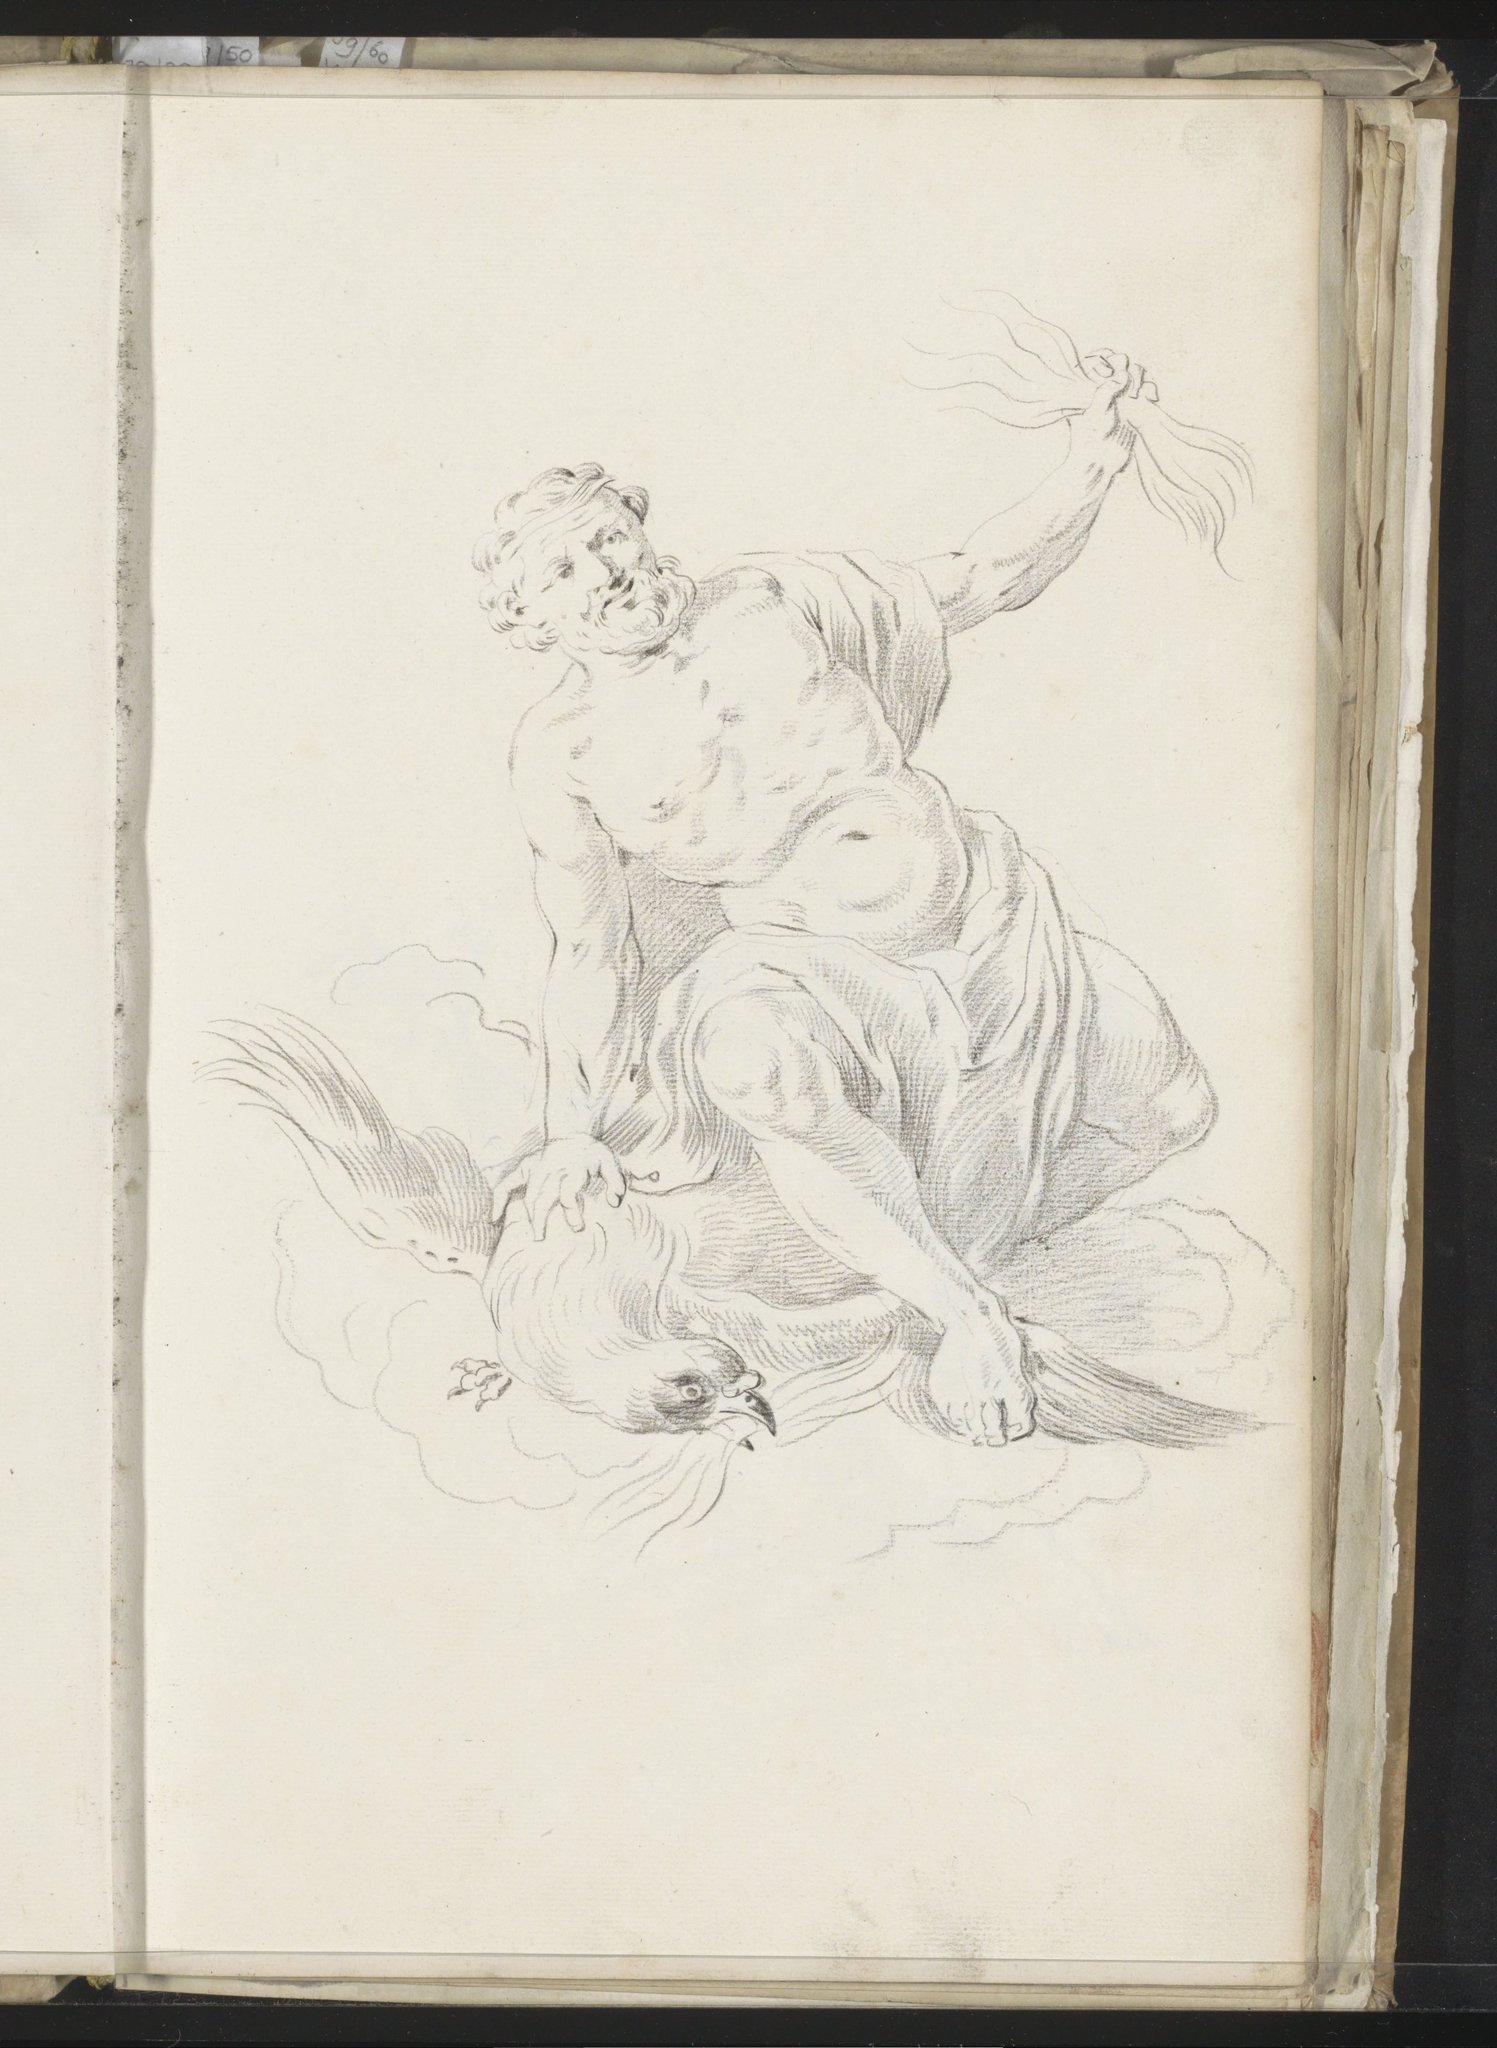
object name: sketchbook leaf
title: Jupiter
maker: jacob toorenvliet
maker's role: draughtsman, painter, print maker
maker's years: 1640-1719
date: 1701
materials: chalk, paper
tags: (story of) jupiter (zeus), attributes of jupiter: eagle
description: Jupiter zit op een adelaar en heeft een bliksemschicht in zijn linkerhand. Blad 15 recto uit een schetsboek met 63 bladen.